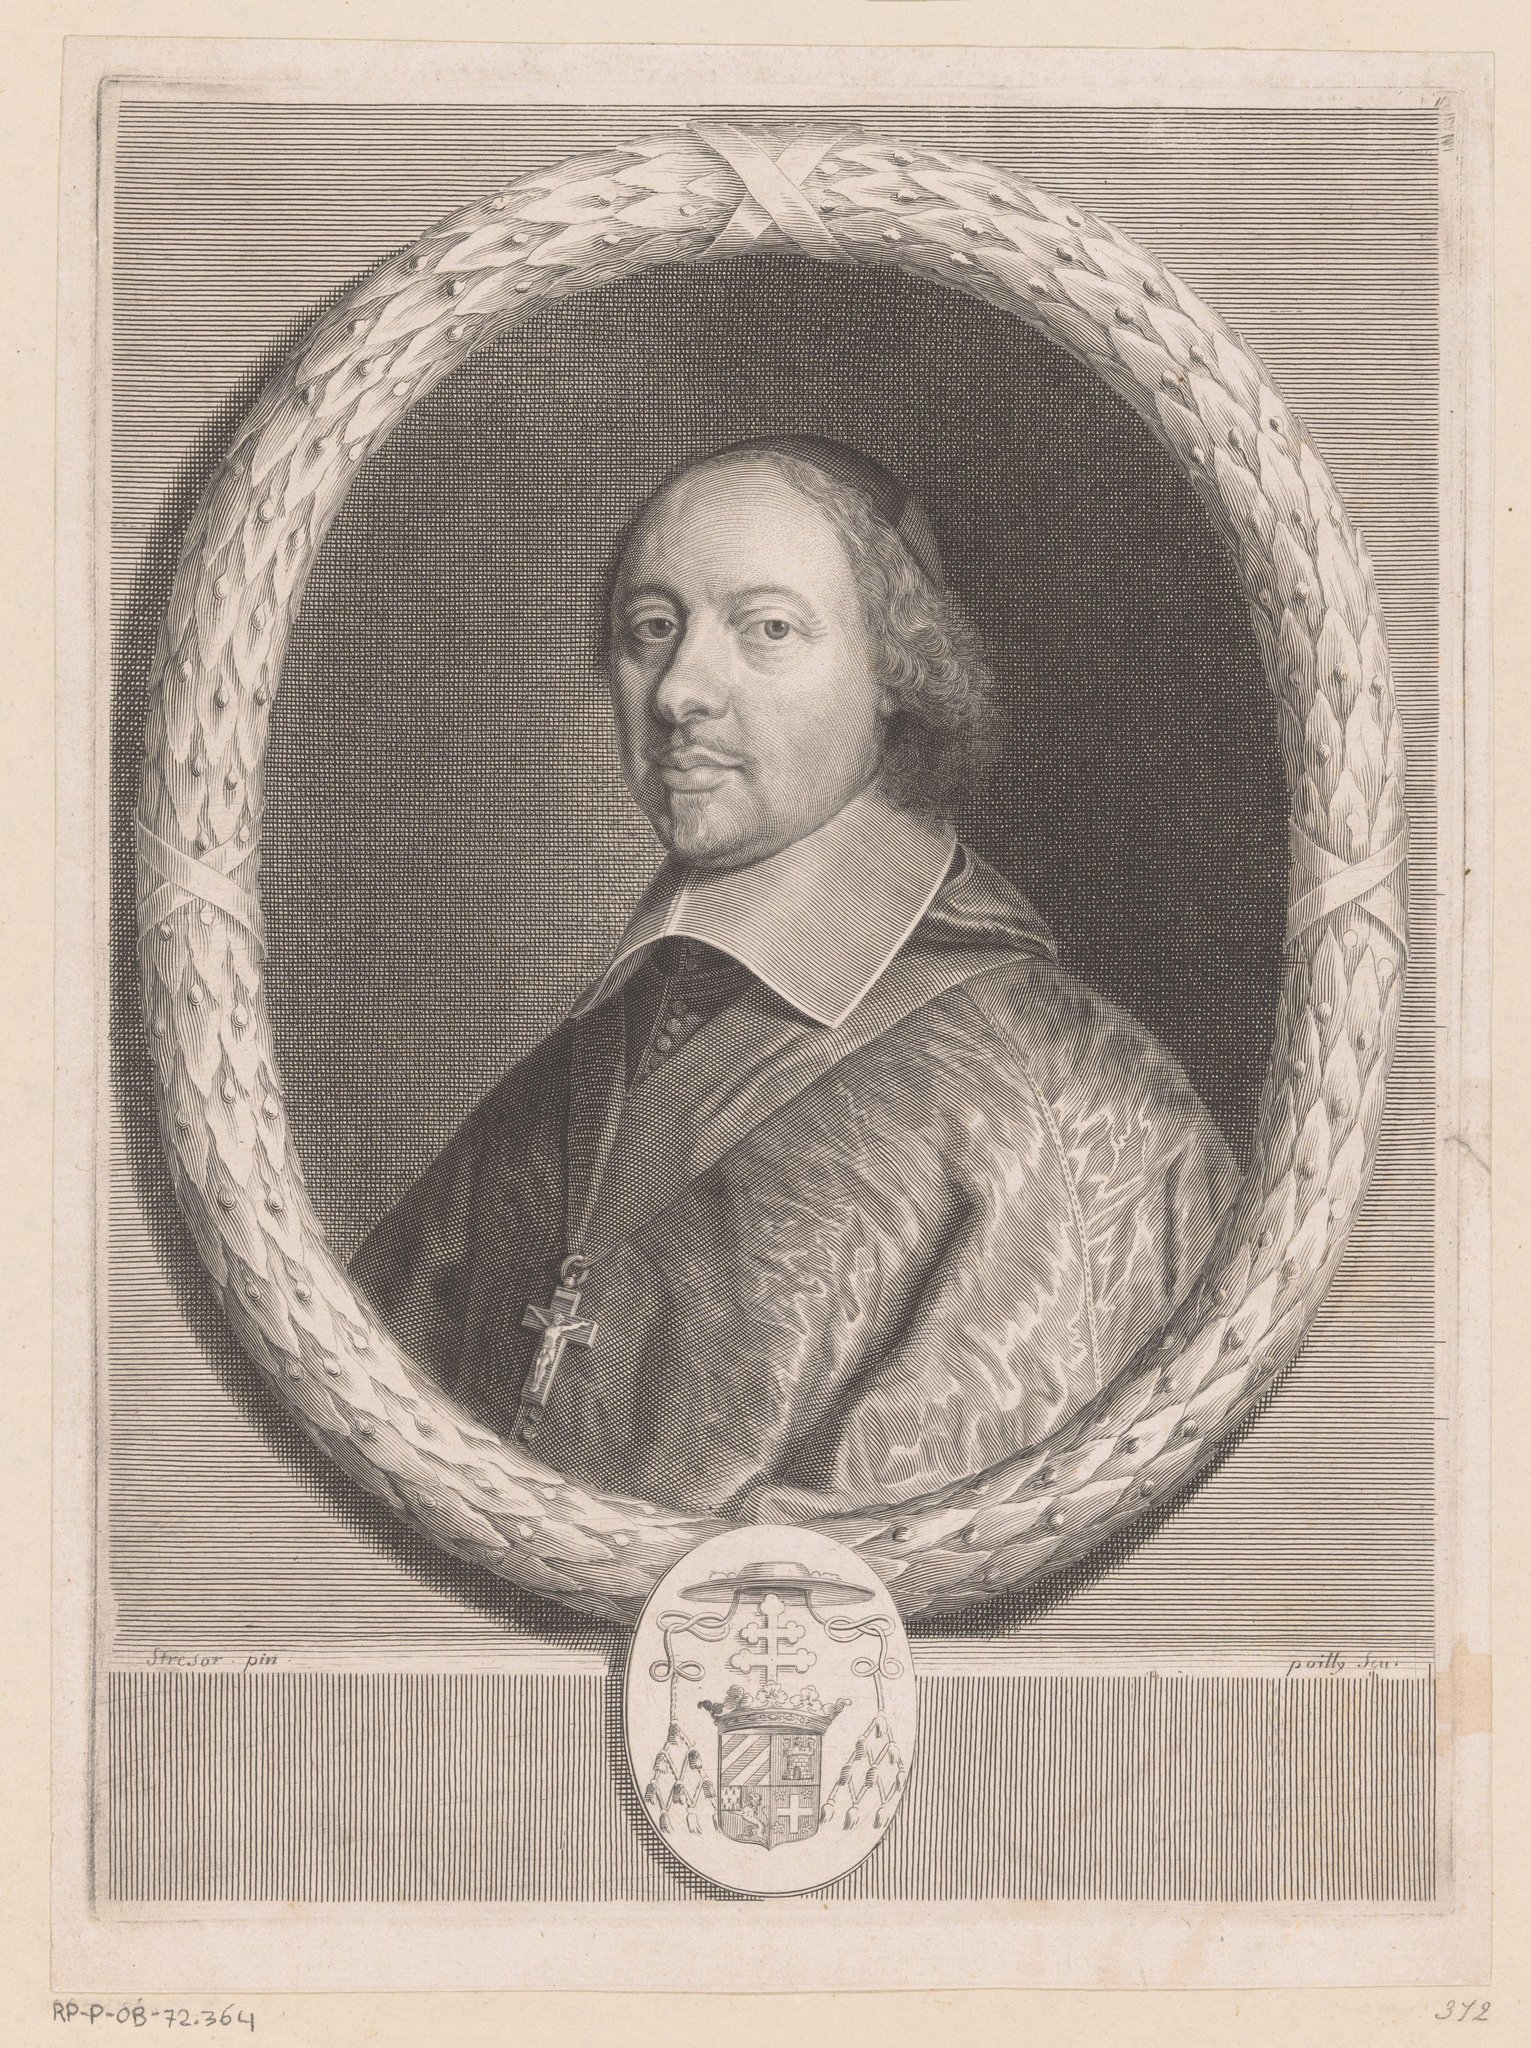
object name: print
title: Portret van François Adhémar de Monteil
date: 1636-1696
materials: paper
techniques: engraving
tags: archbishop, bishop, etc. (roman catholic), historical persons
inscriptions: collector's mark: Lugt 240